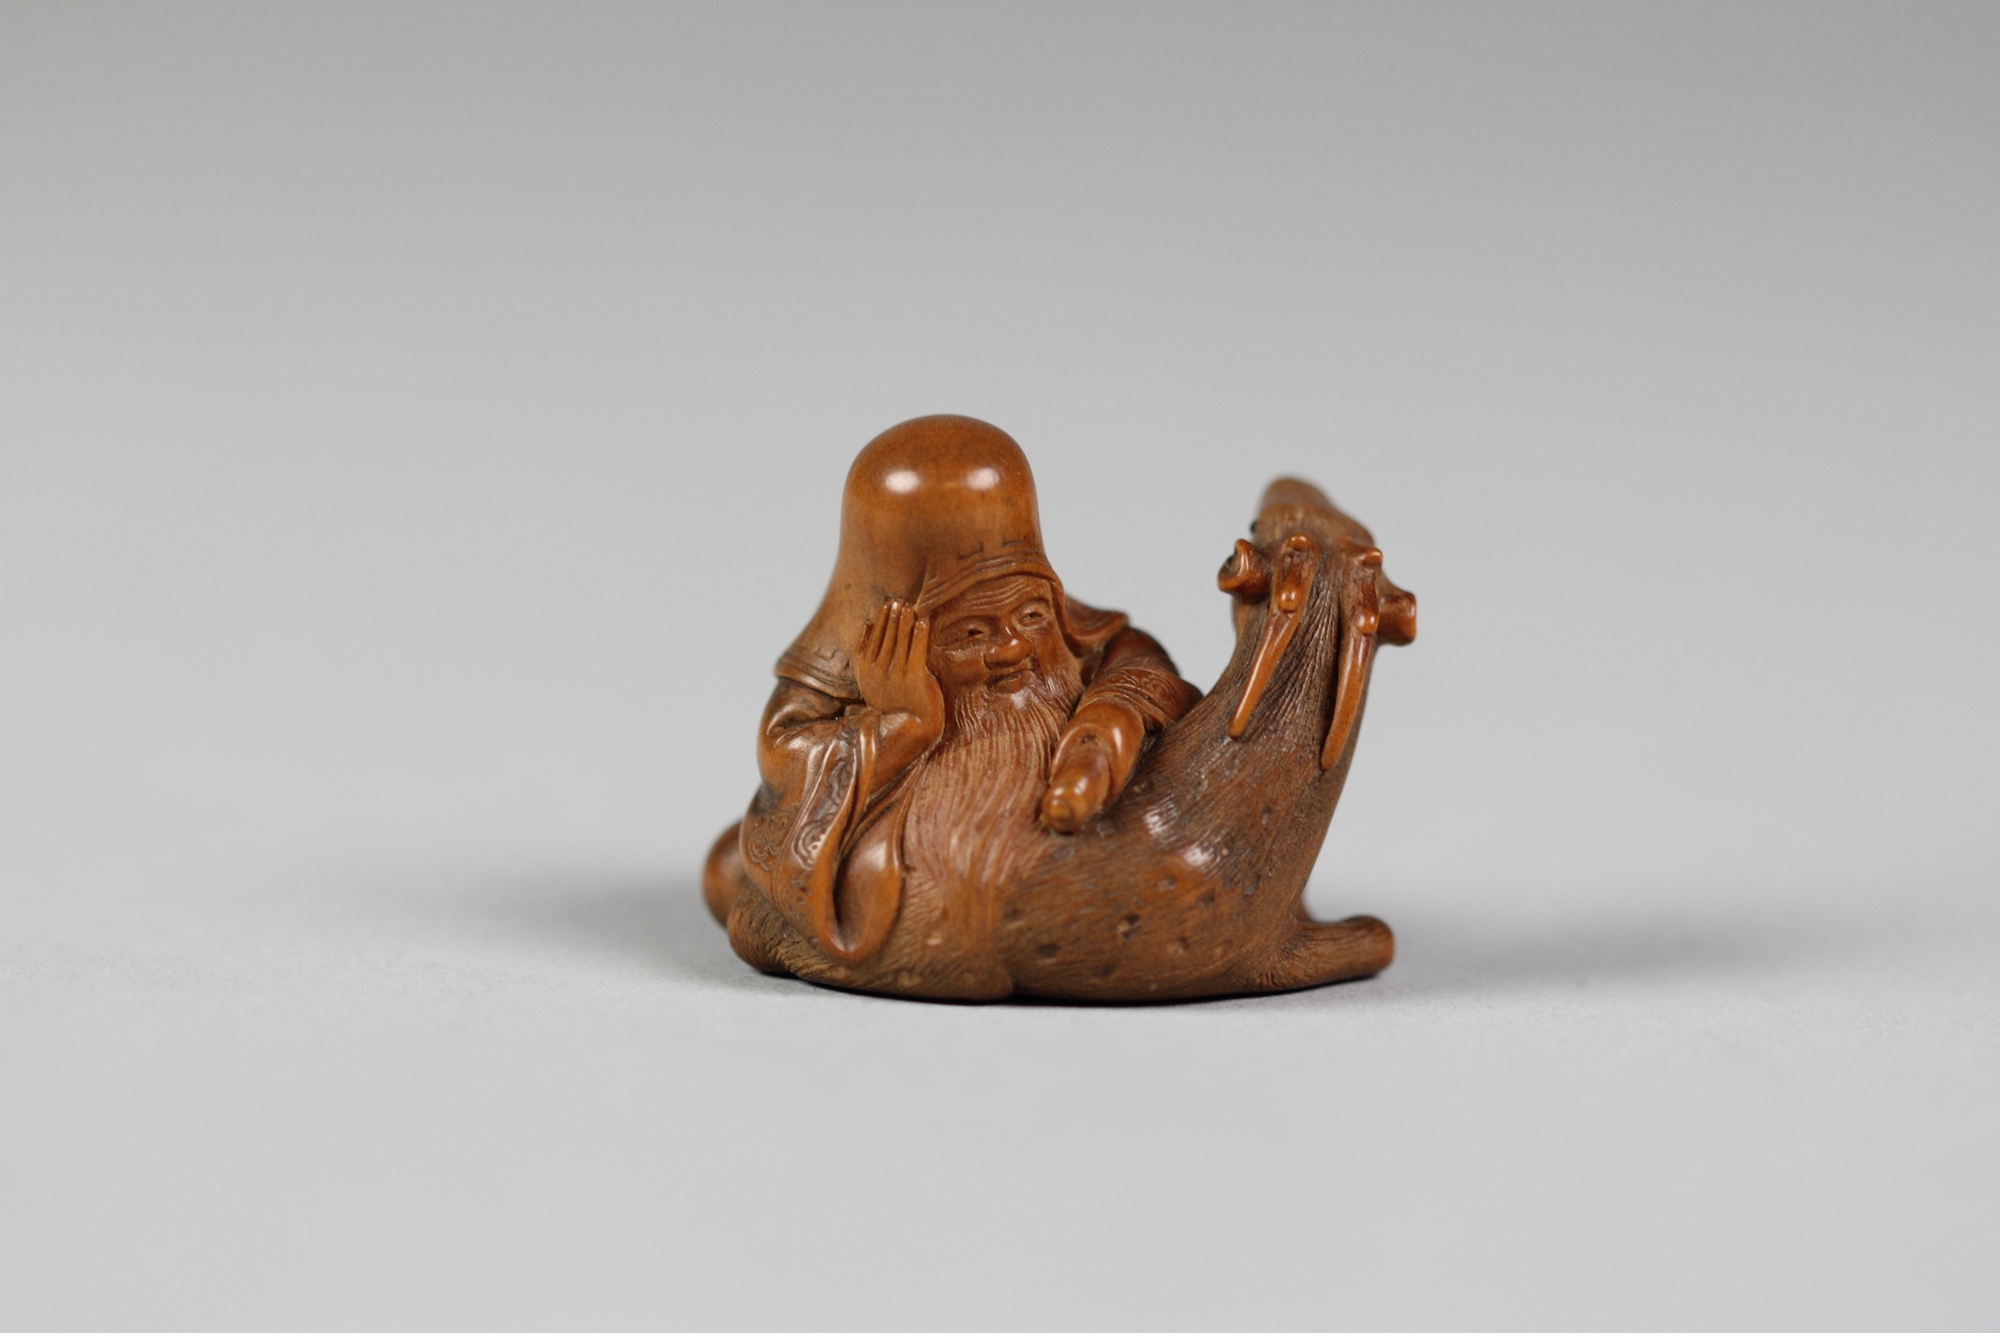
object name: netsuke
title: Netsuke of Fukurokujin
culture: japanese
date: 1801-1900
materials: wood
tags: animals,men